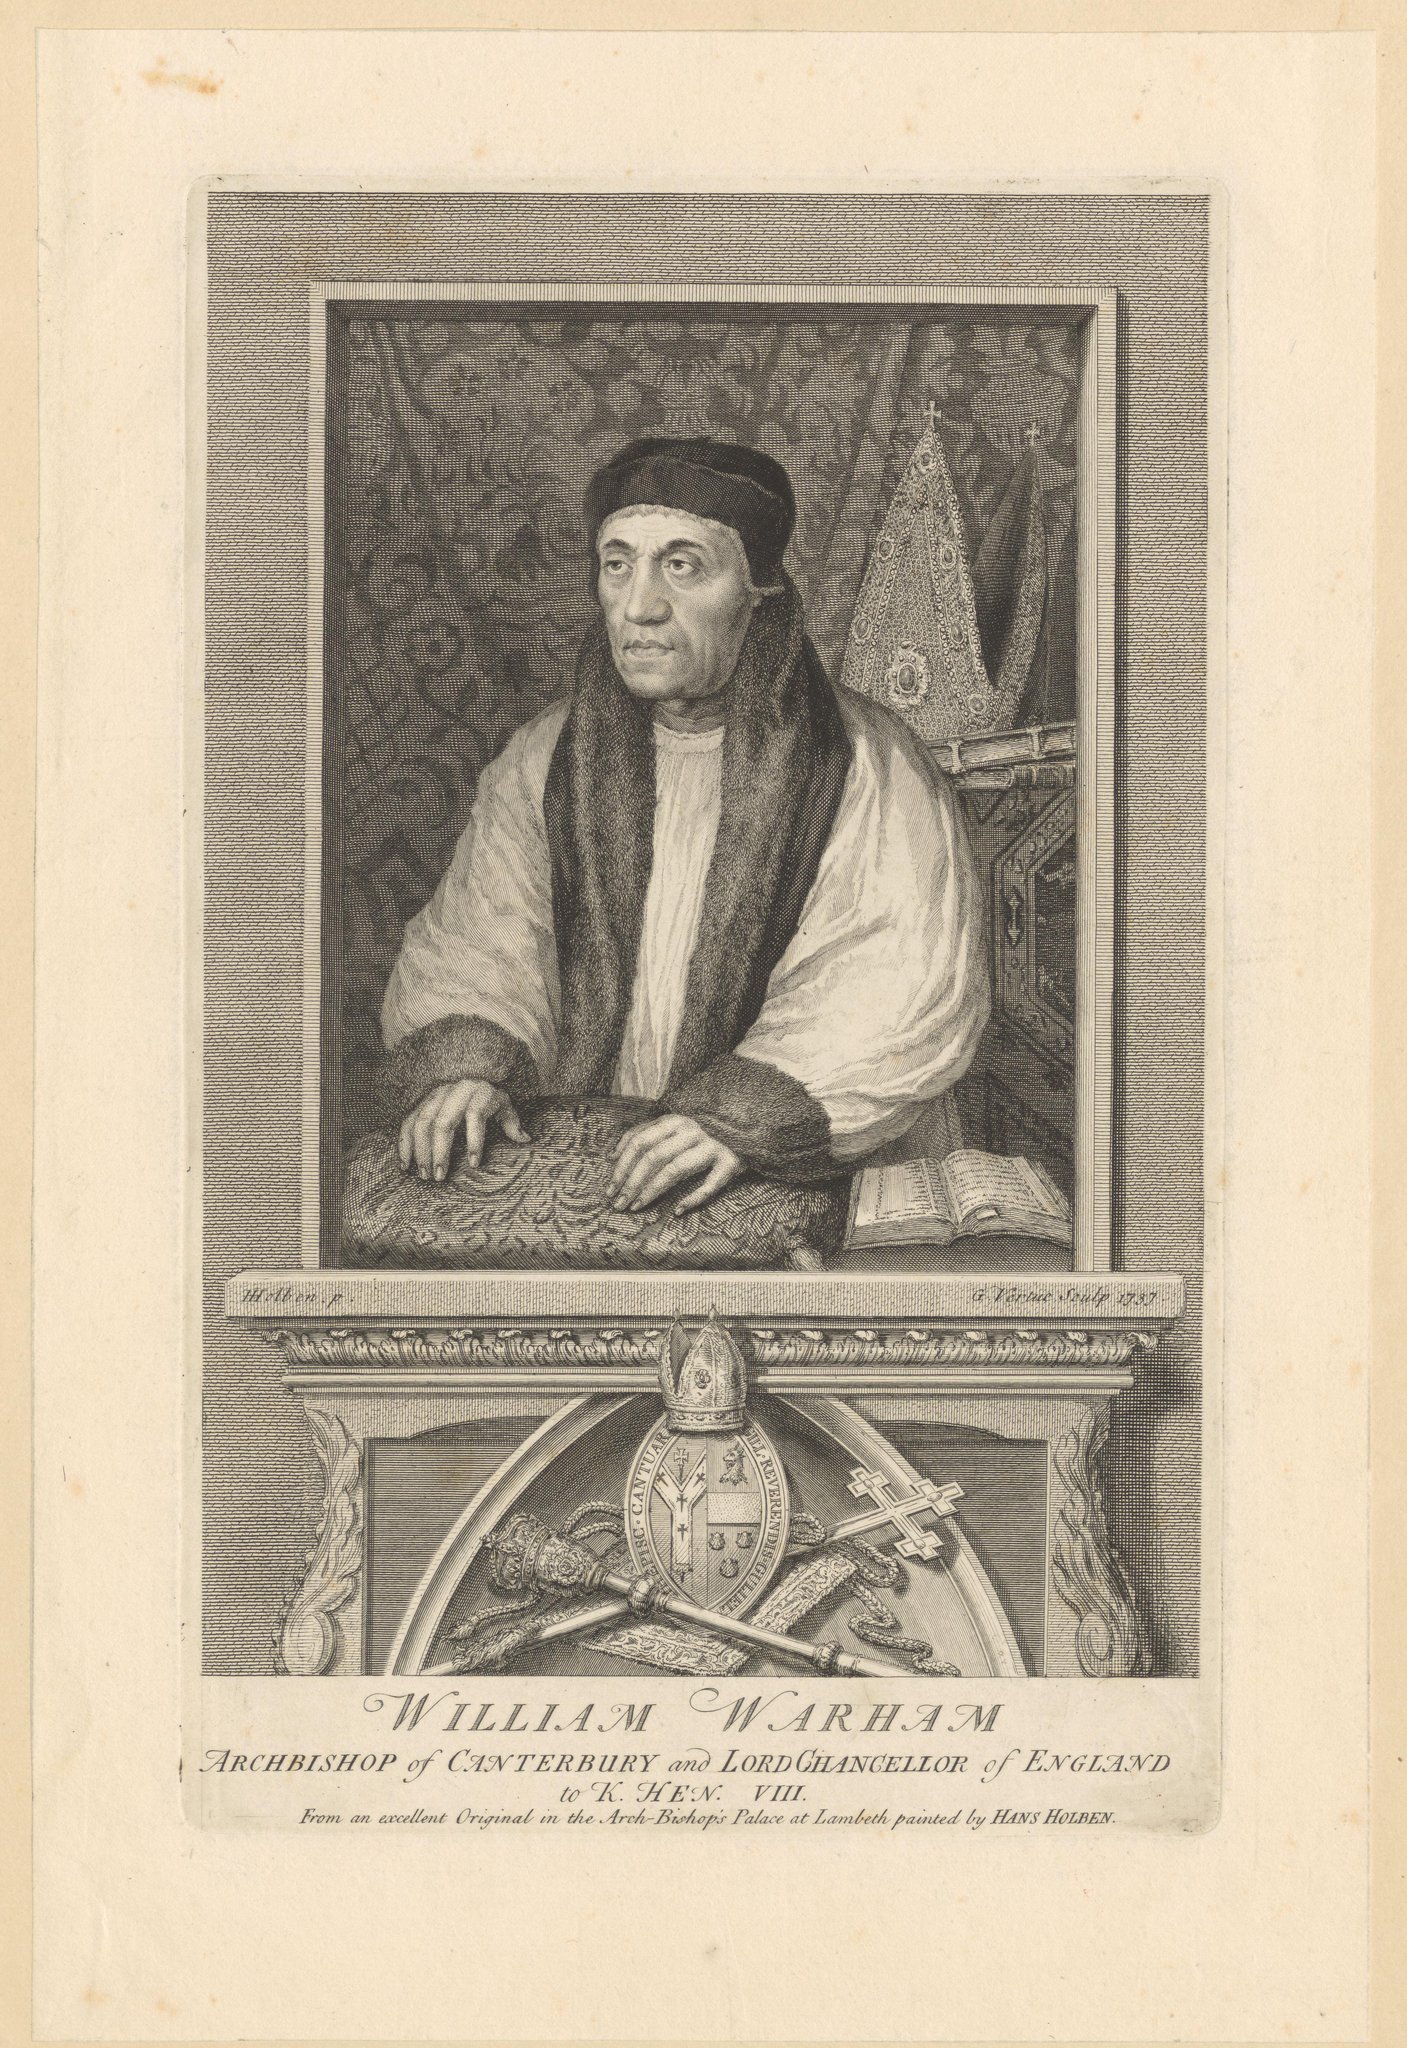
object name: print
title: Portret van William Warham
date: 1737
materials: paper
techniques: engraving, etching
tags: archbishop, bishop, etc. (roman catholic), historical persons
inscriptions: collector's mark: Lugt 240